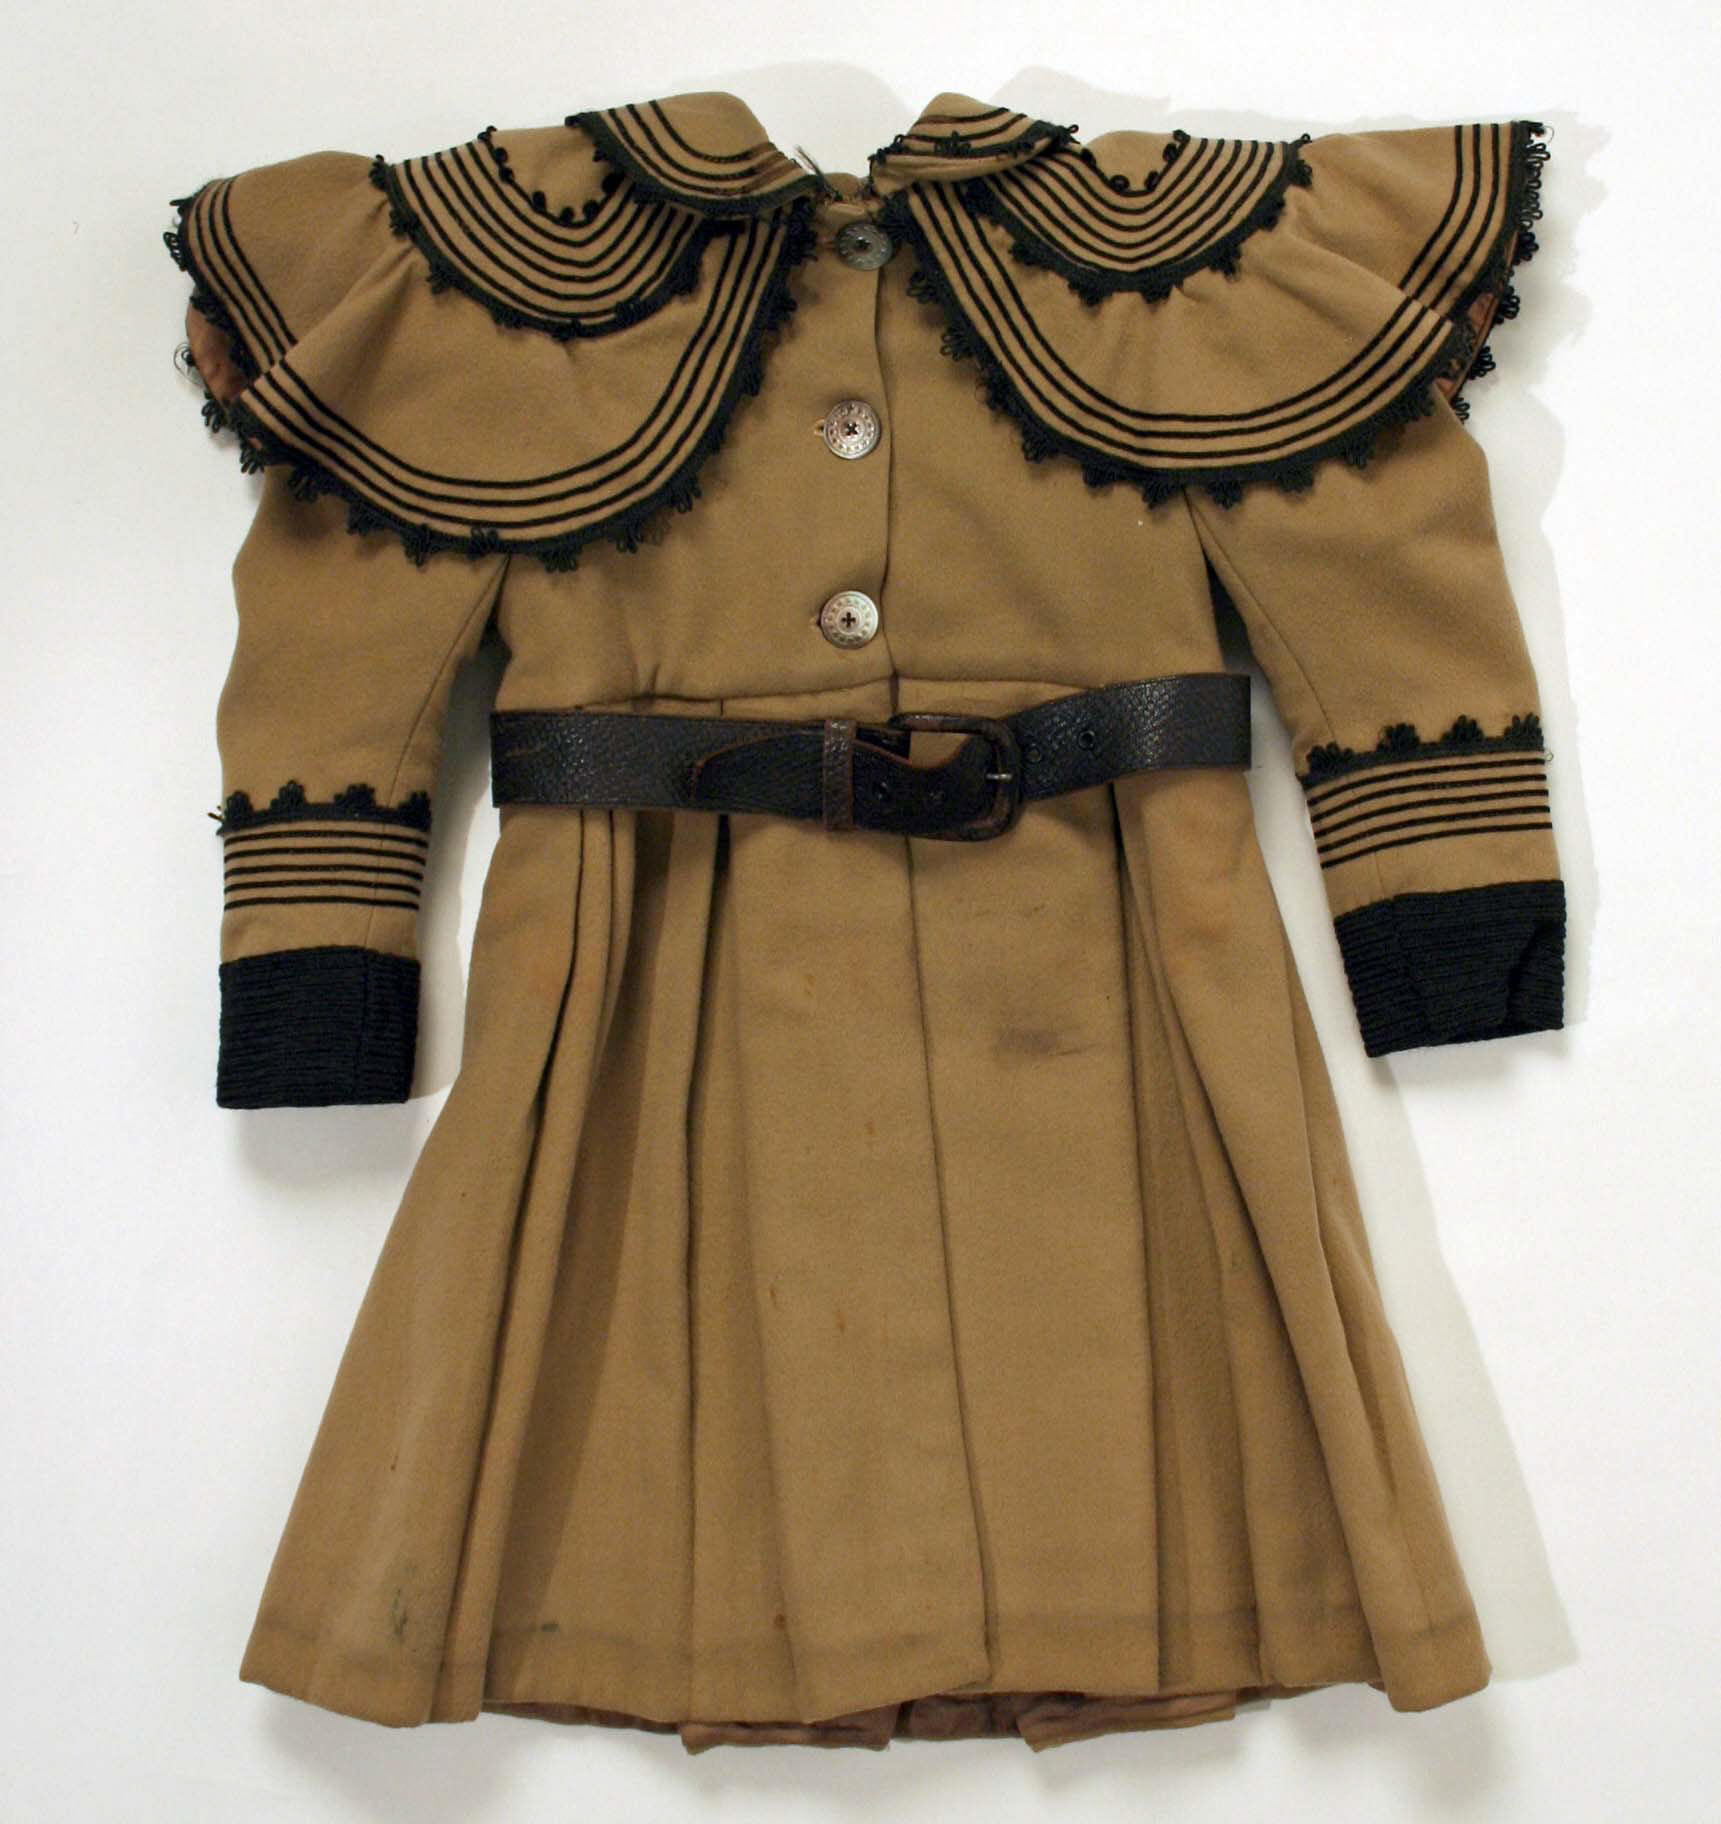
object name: coat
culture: american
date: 1895-1899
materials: cotton, leather, silk, wool